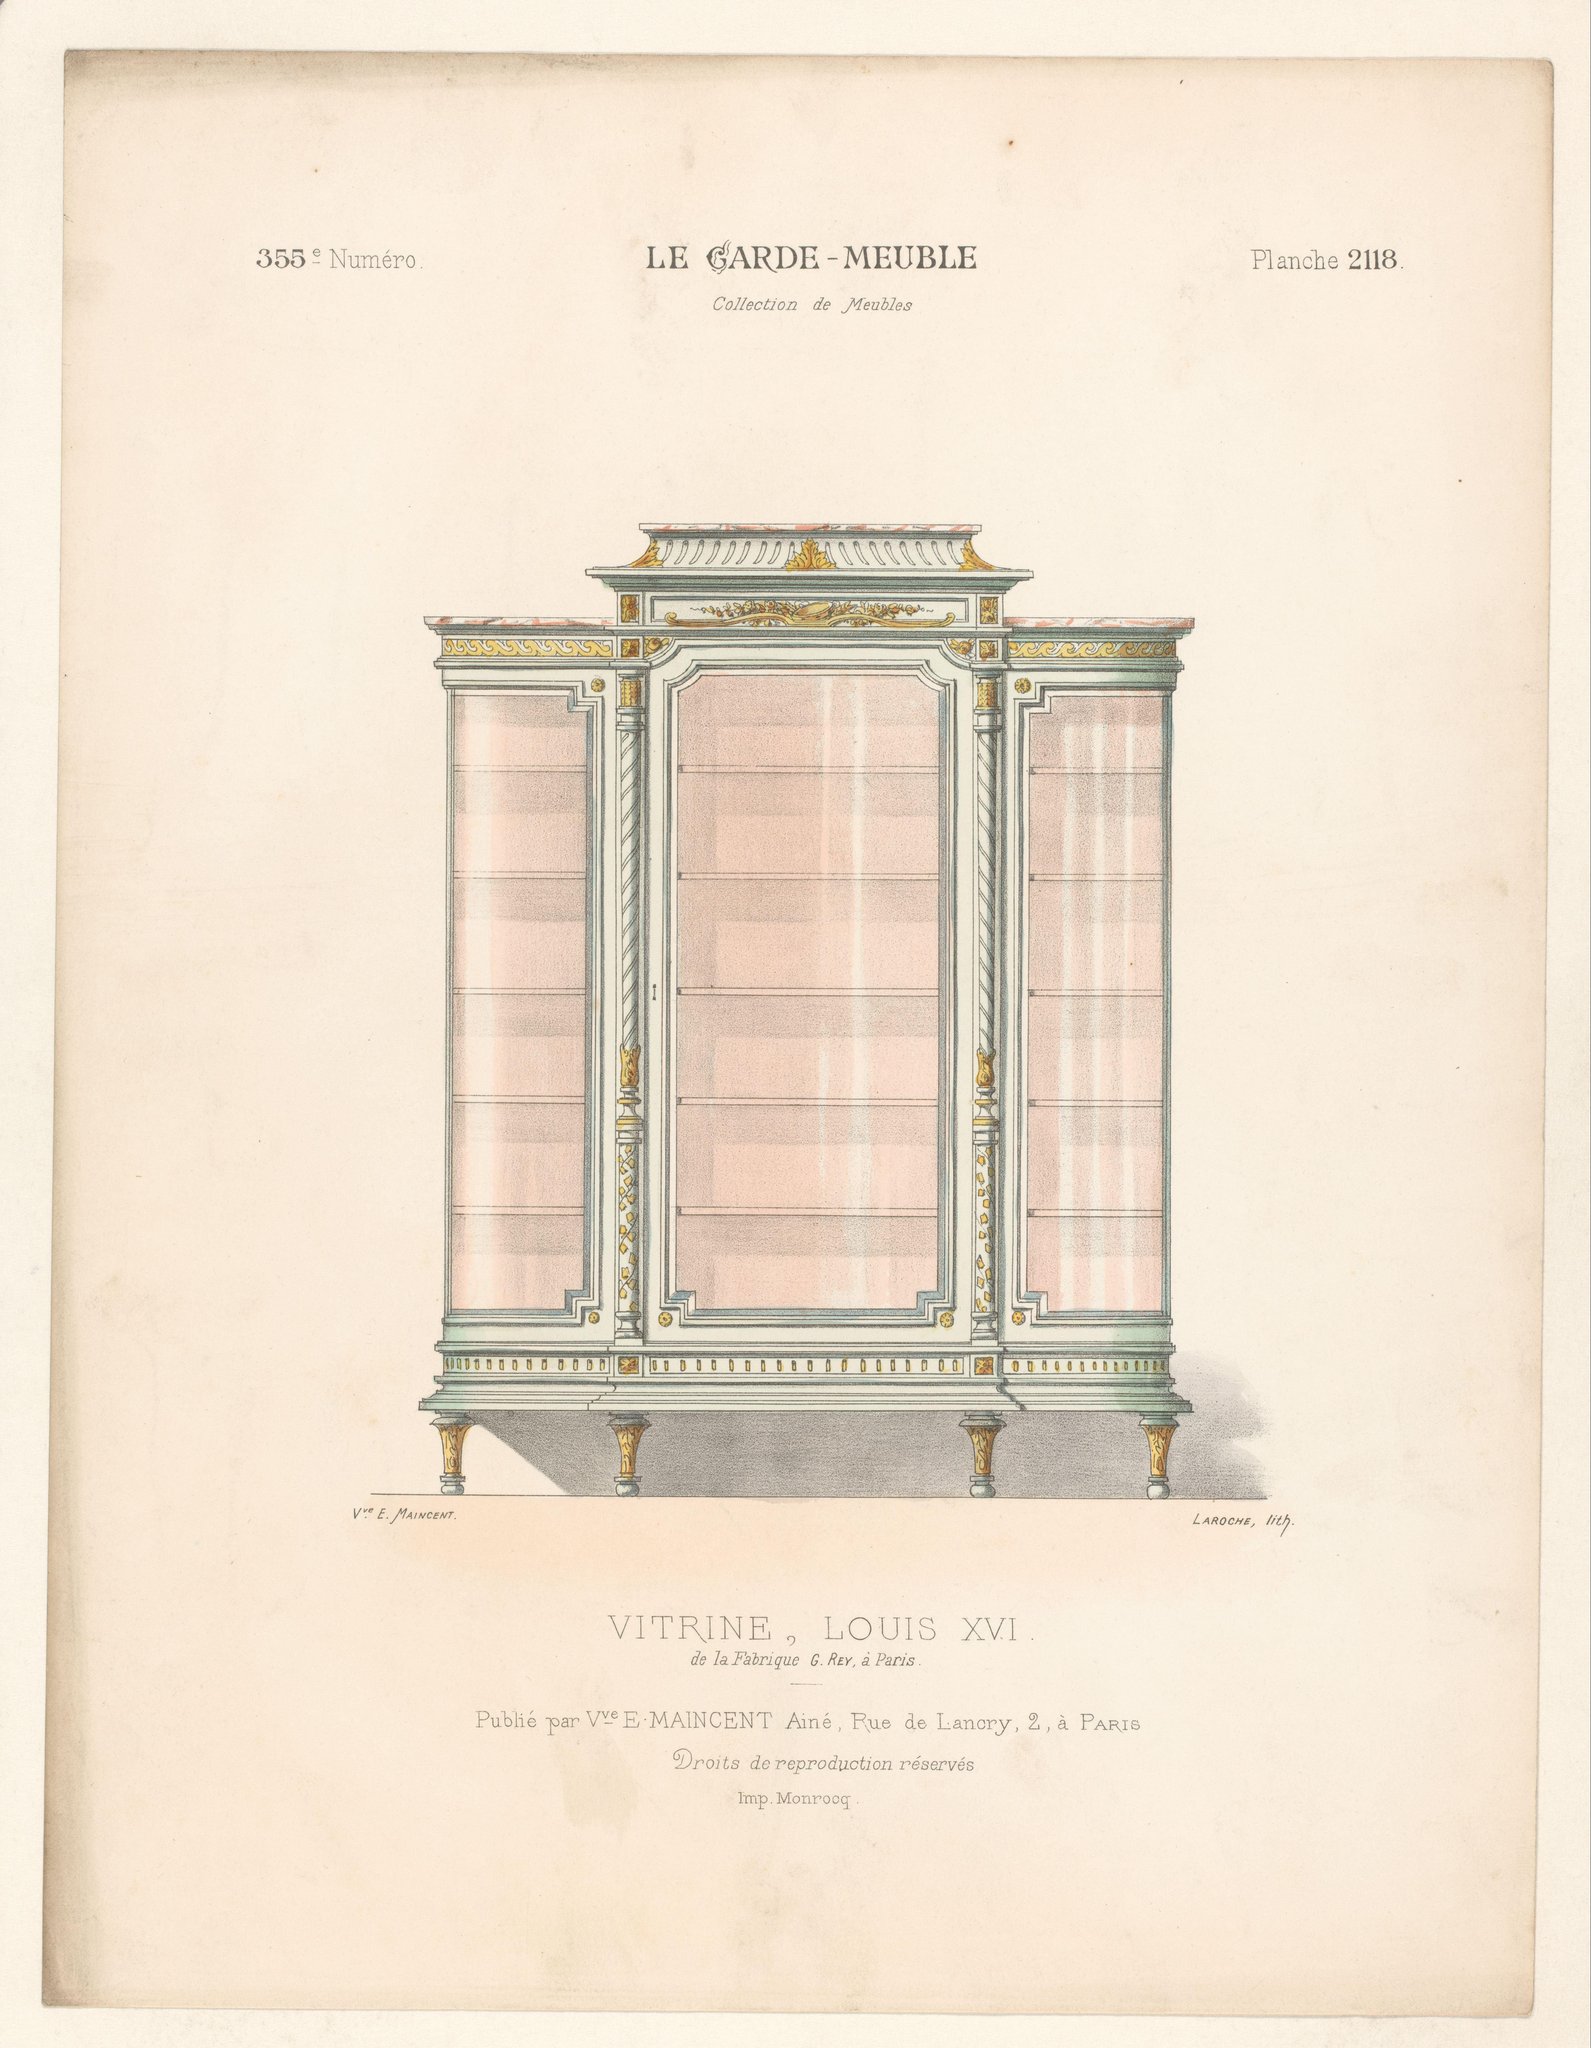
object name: print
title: Vitrinekast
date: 1895-1935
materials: paper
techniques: hand coloring, lithograph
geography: paris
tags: furniture for storage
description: Ieder Livraison in de serie Le Garde-Meuble bevat negen platen: drie 'sièges' (zitmeubels), drie 'meubles' (diverse meubels zoals tafels en kasten) en drie 'tentures' (gordijnen en draperieën).